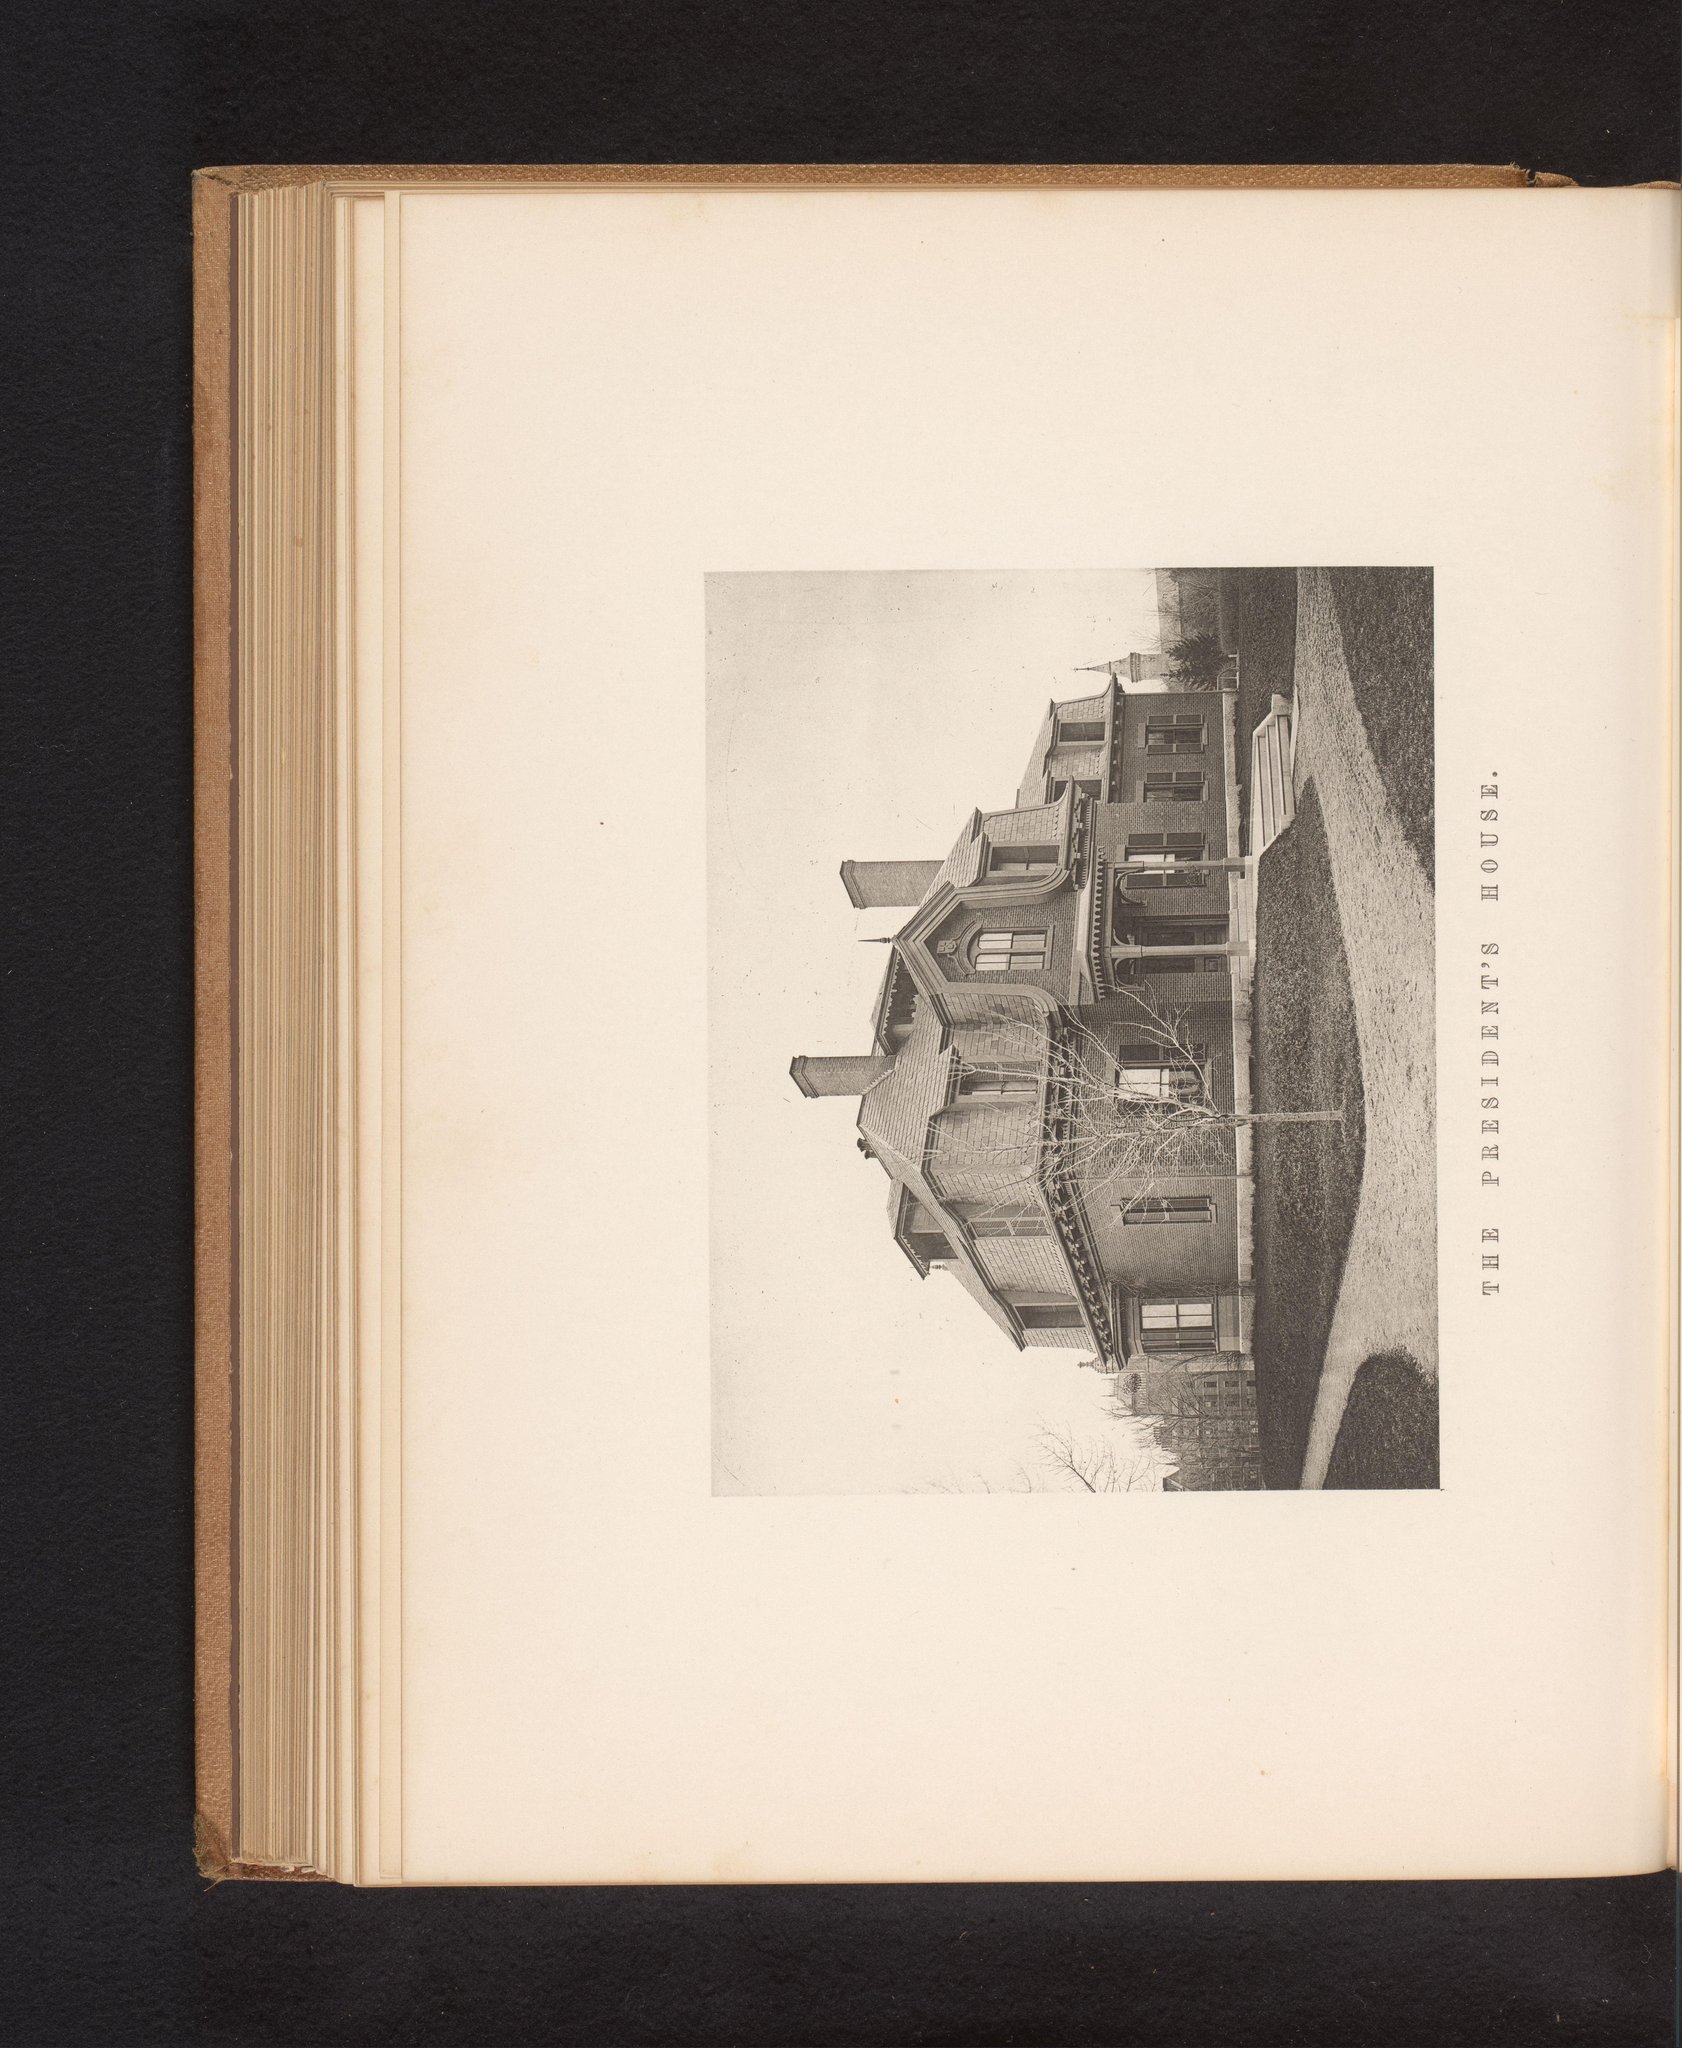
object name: page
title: Gezicht op de directeurswoning van de Harvard-universiteit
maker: Anonymous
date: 1870-1875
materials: paper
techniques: photograph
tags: detached house in city, university building, college